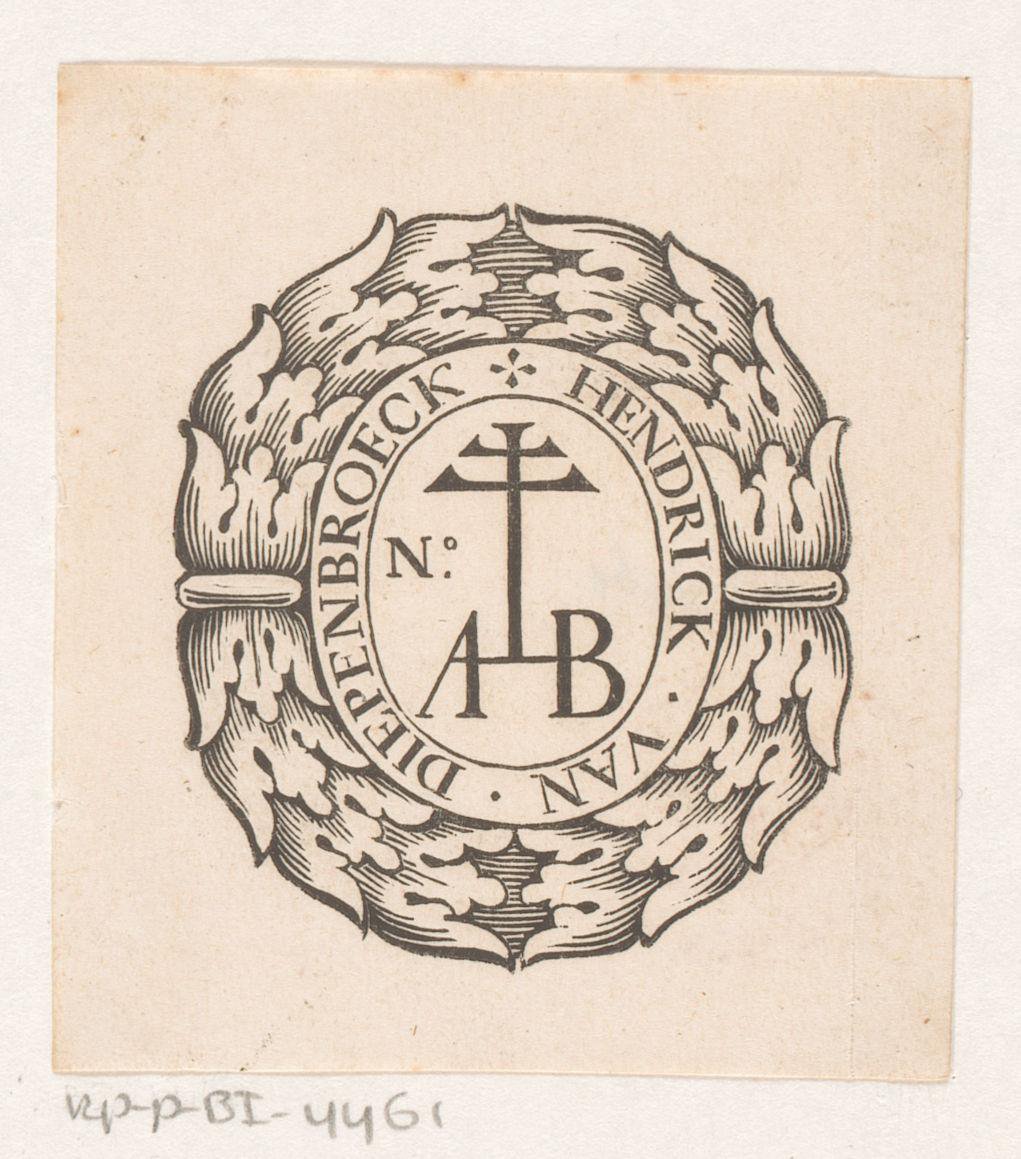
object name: print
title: Vignet van Hendrick van Diepenbroeck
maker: Anonymous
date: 1600-1699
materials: paper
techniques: woodcut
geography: netherlands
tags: vignette, letter combinations such as letterword, anagram, letter square, monogram, etc.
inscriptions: collector's mark: Lugt 240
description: Het monogram van Hendrick van Diepenbroeck in een ovaal met randschift.